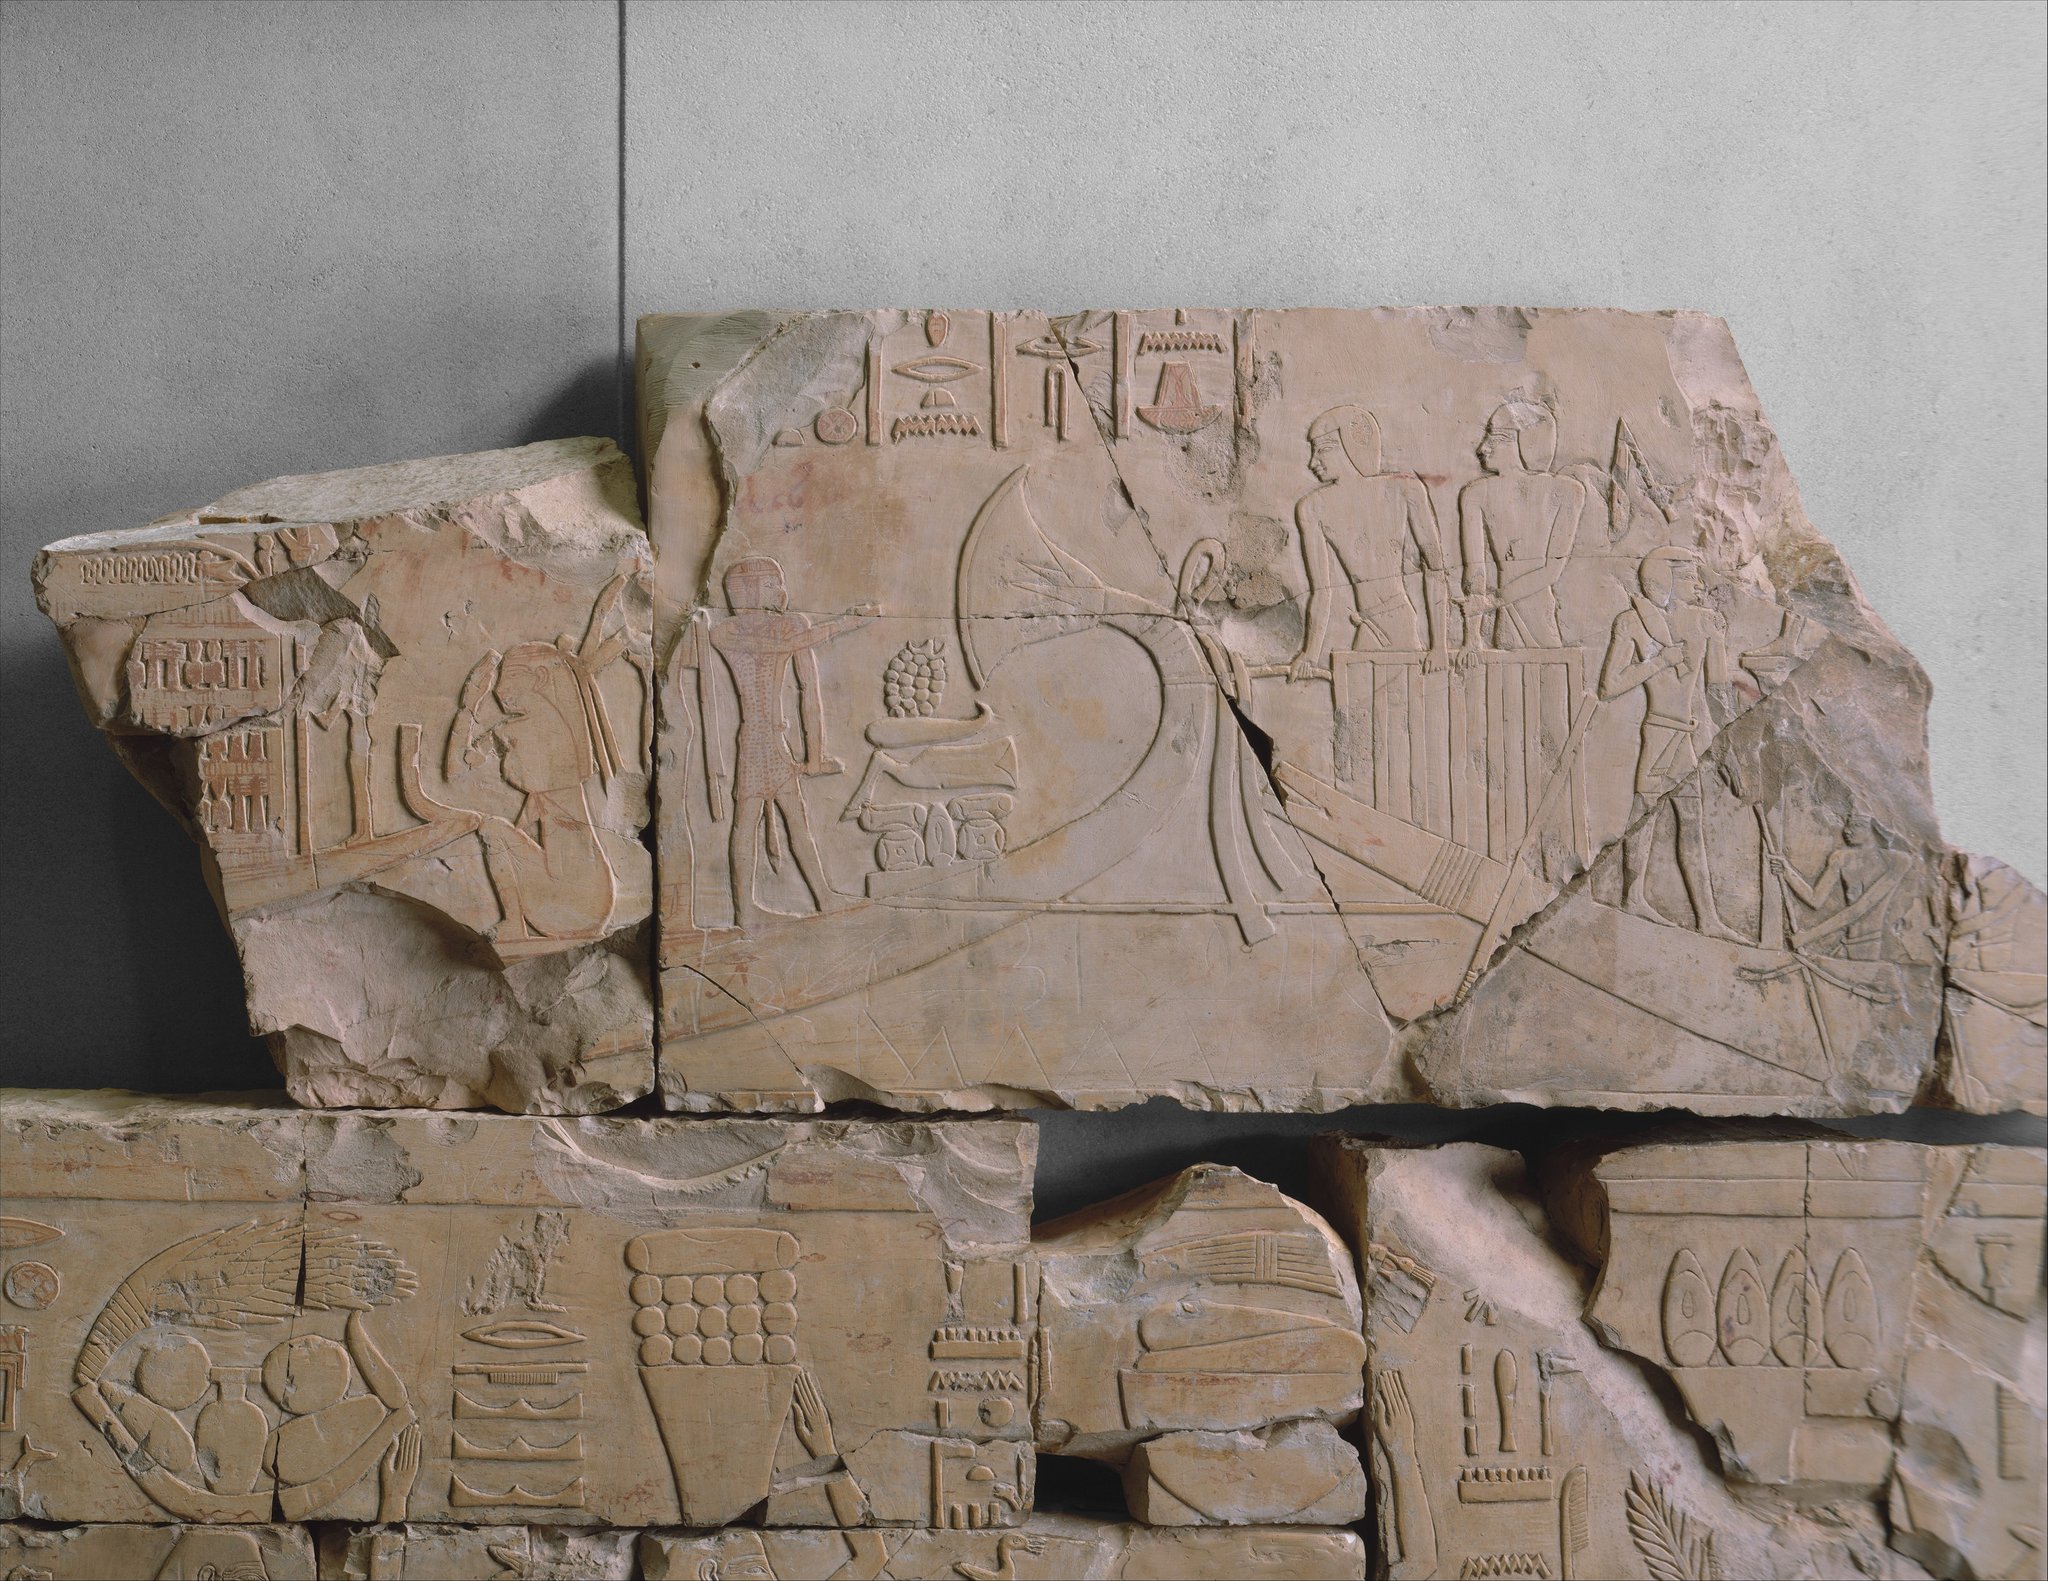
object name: relief, tomb of nespekashuty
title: Reliefs from the Tomb of Nespekashuty (see 23.3.468)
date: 656-610 BCE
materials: limestone, paint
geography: egypt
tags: hieroglyphs